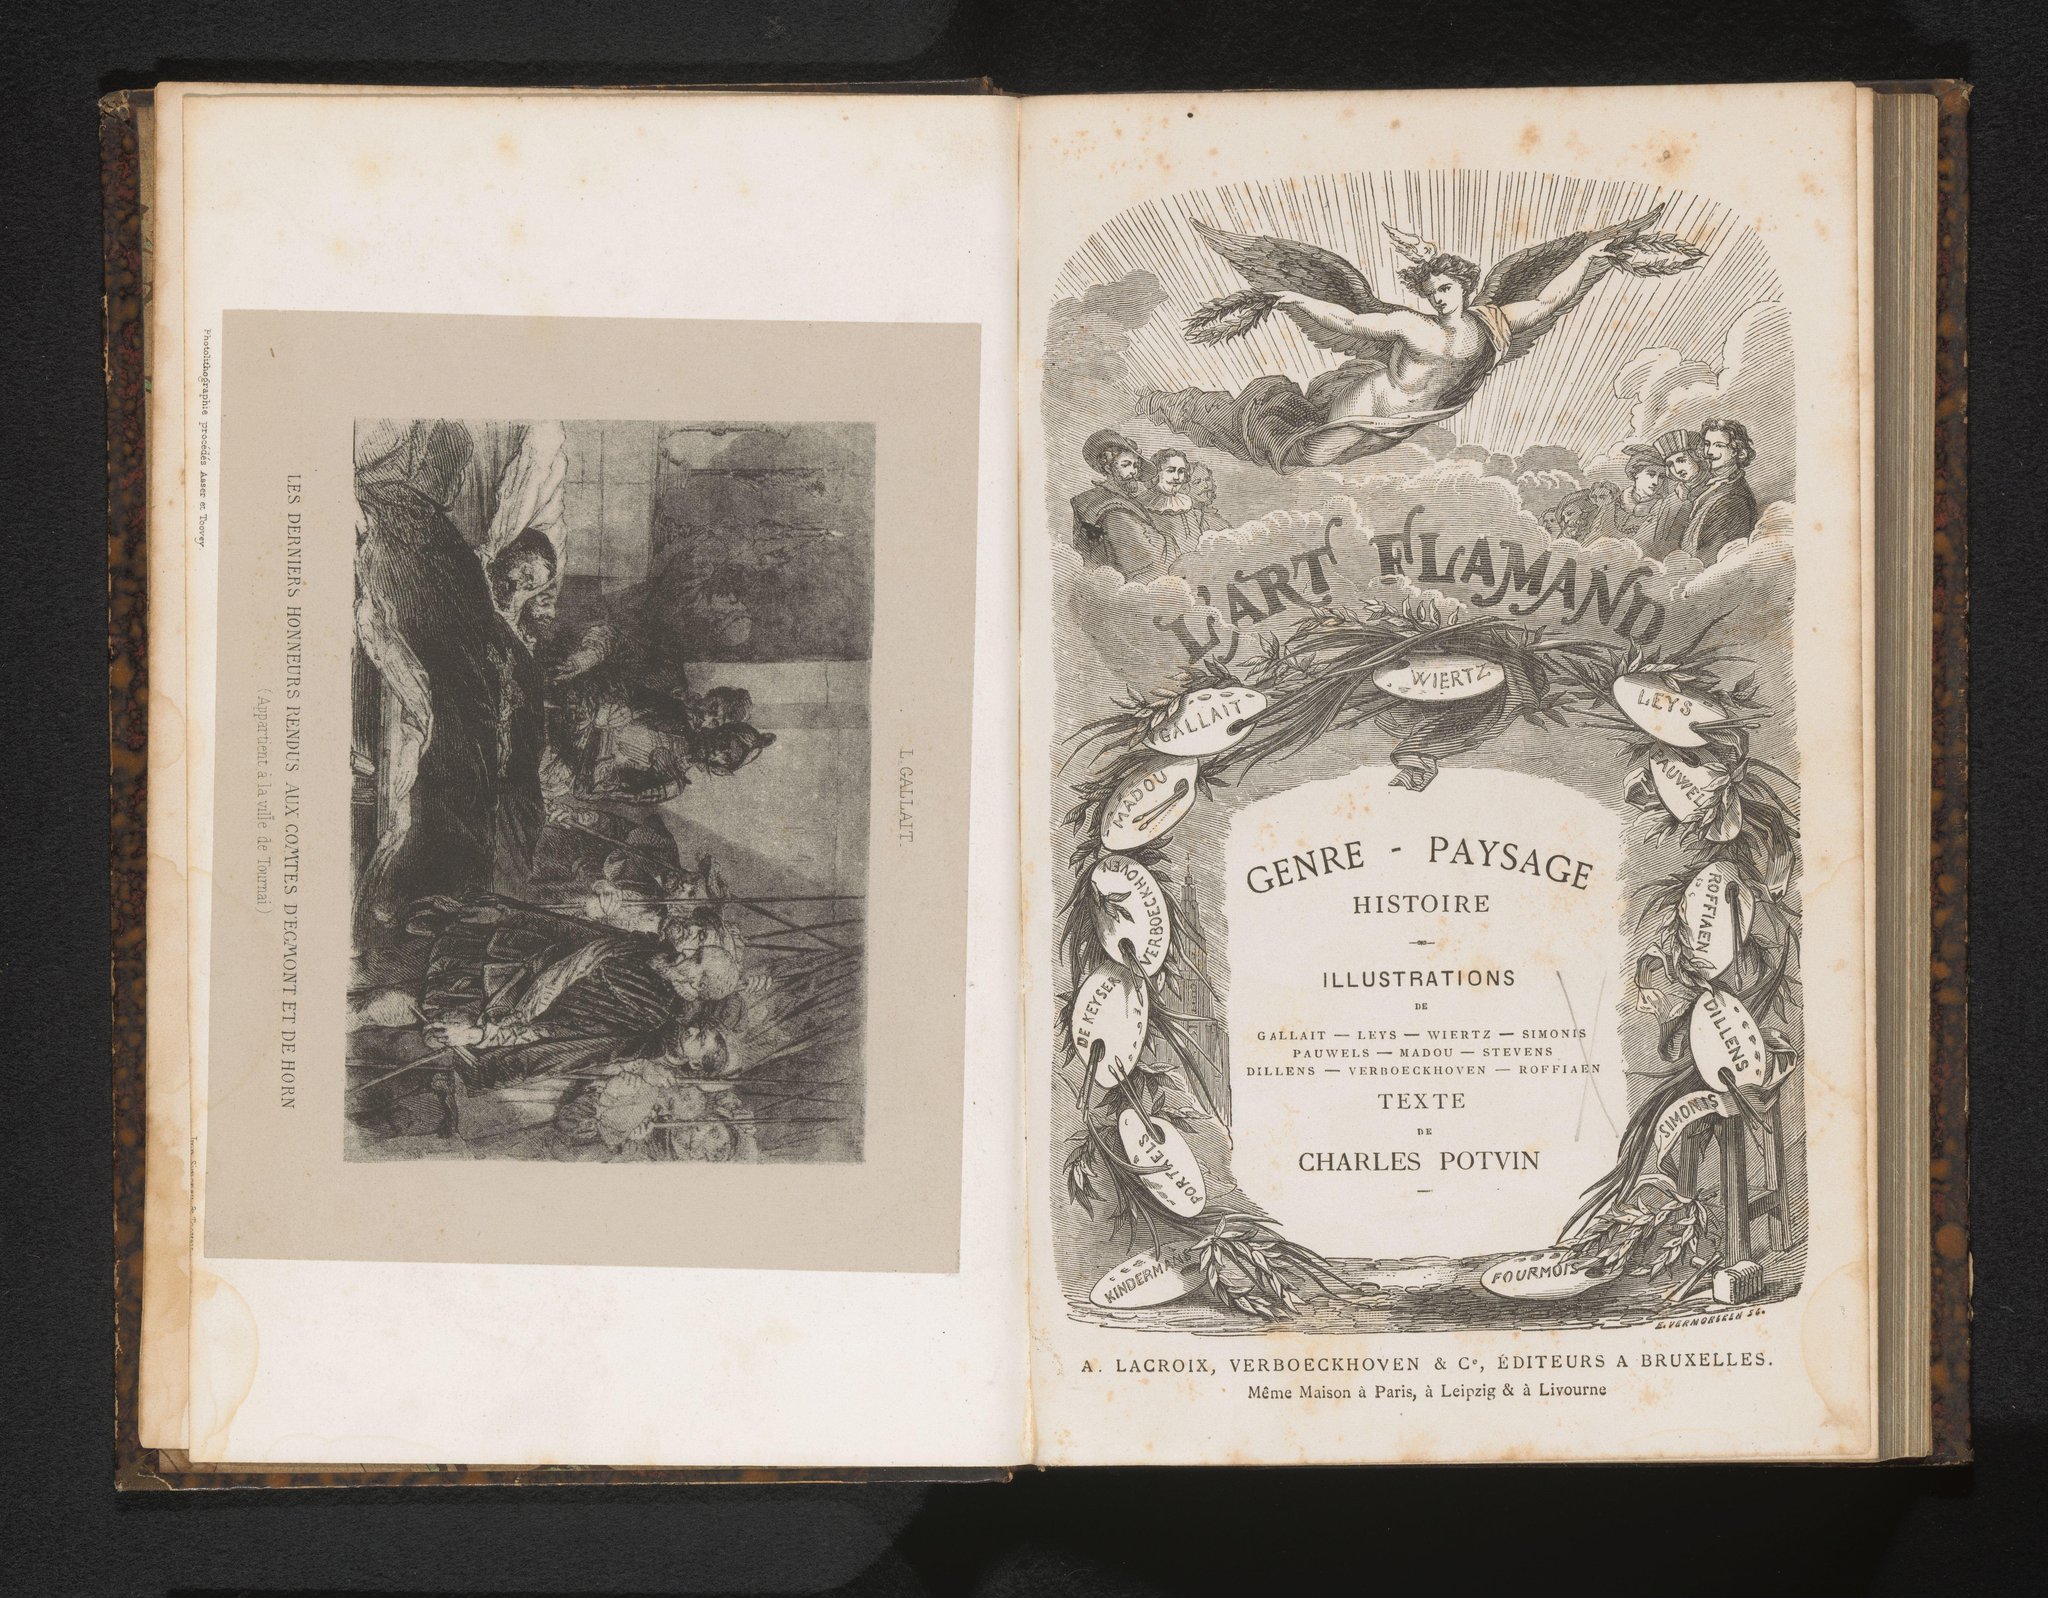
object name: book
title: L'art flamand : genre - paysage - histoire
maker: charles potvin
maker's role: filosoof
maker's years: 1818-1902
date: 1867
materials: cardboard, leather, paper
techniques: marbling, photolithography, printing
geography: brussels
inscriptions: annotation: ‘MAY/ 1984’